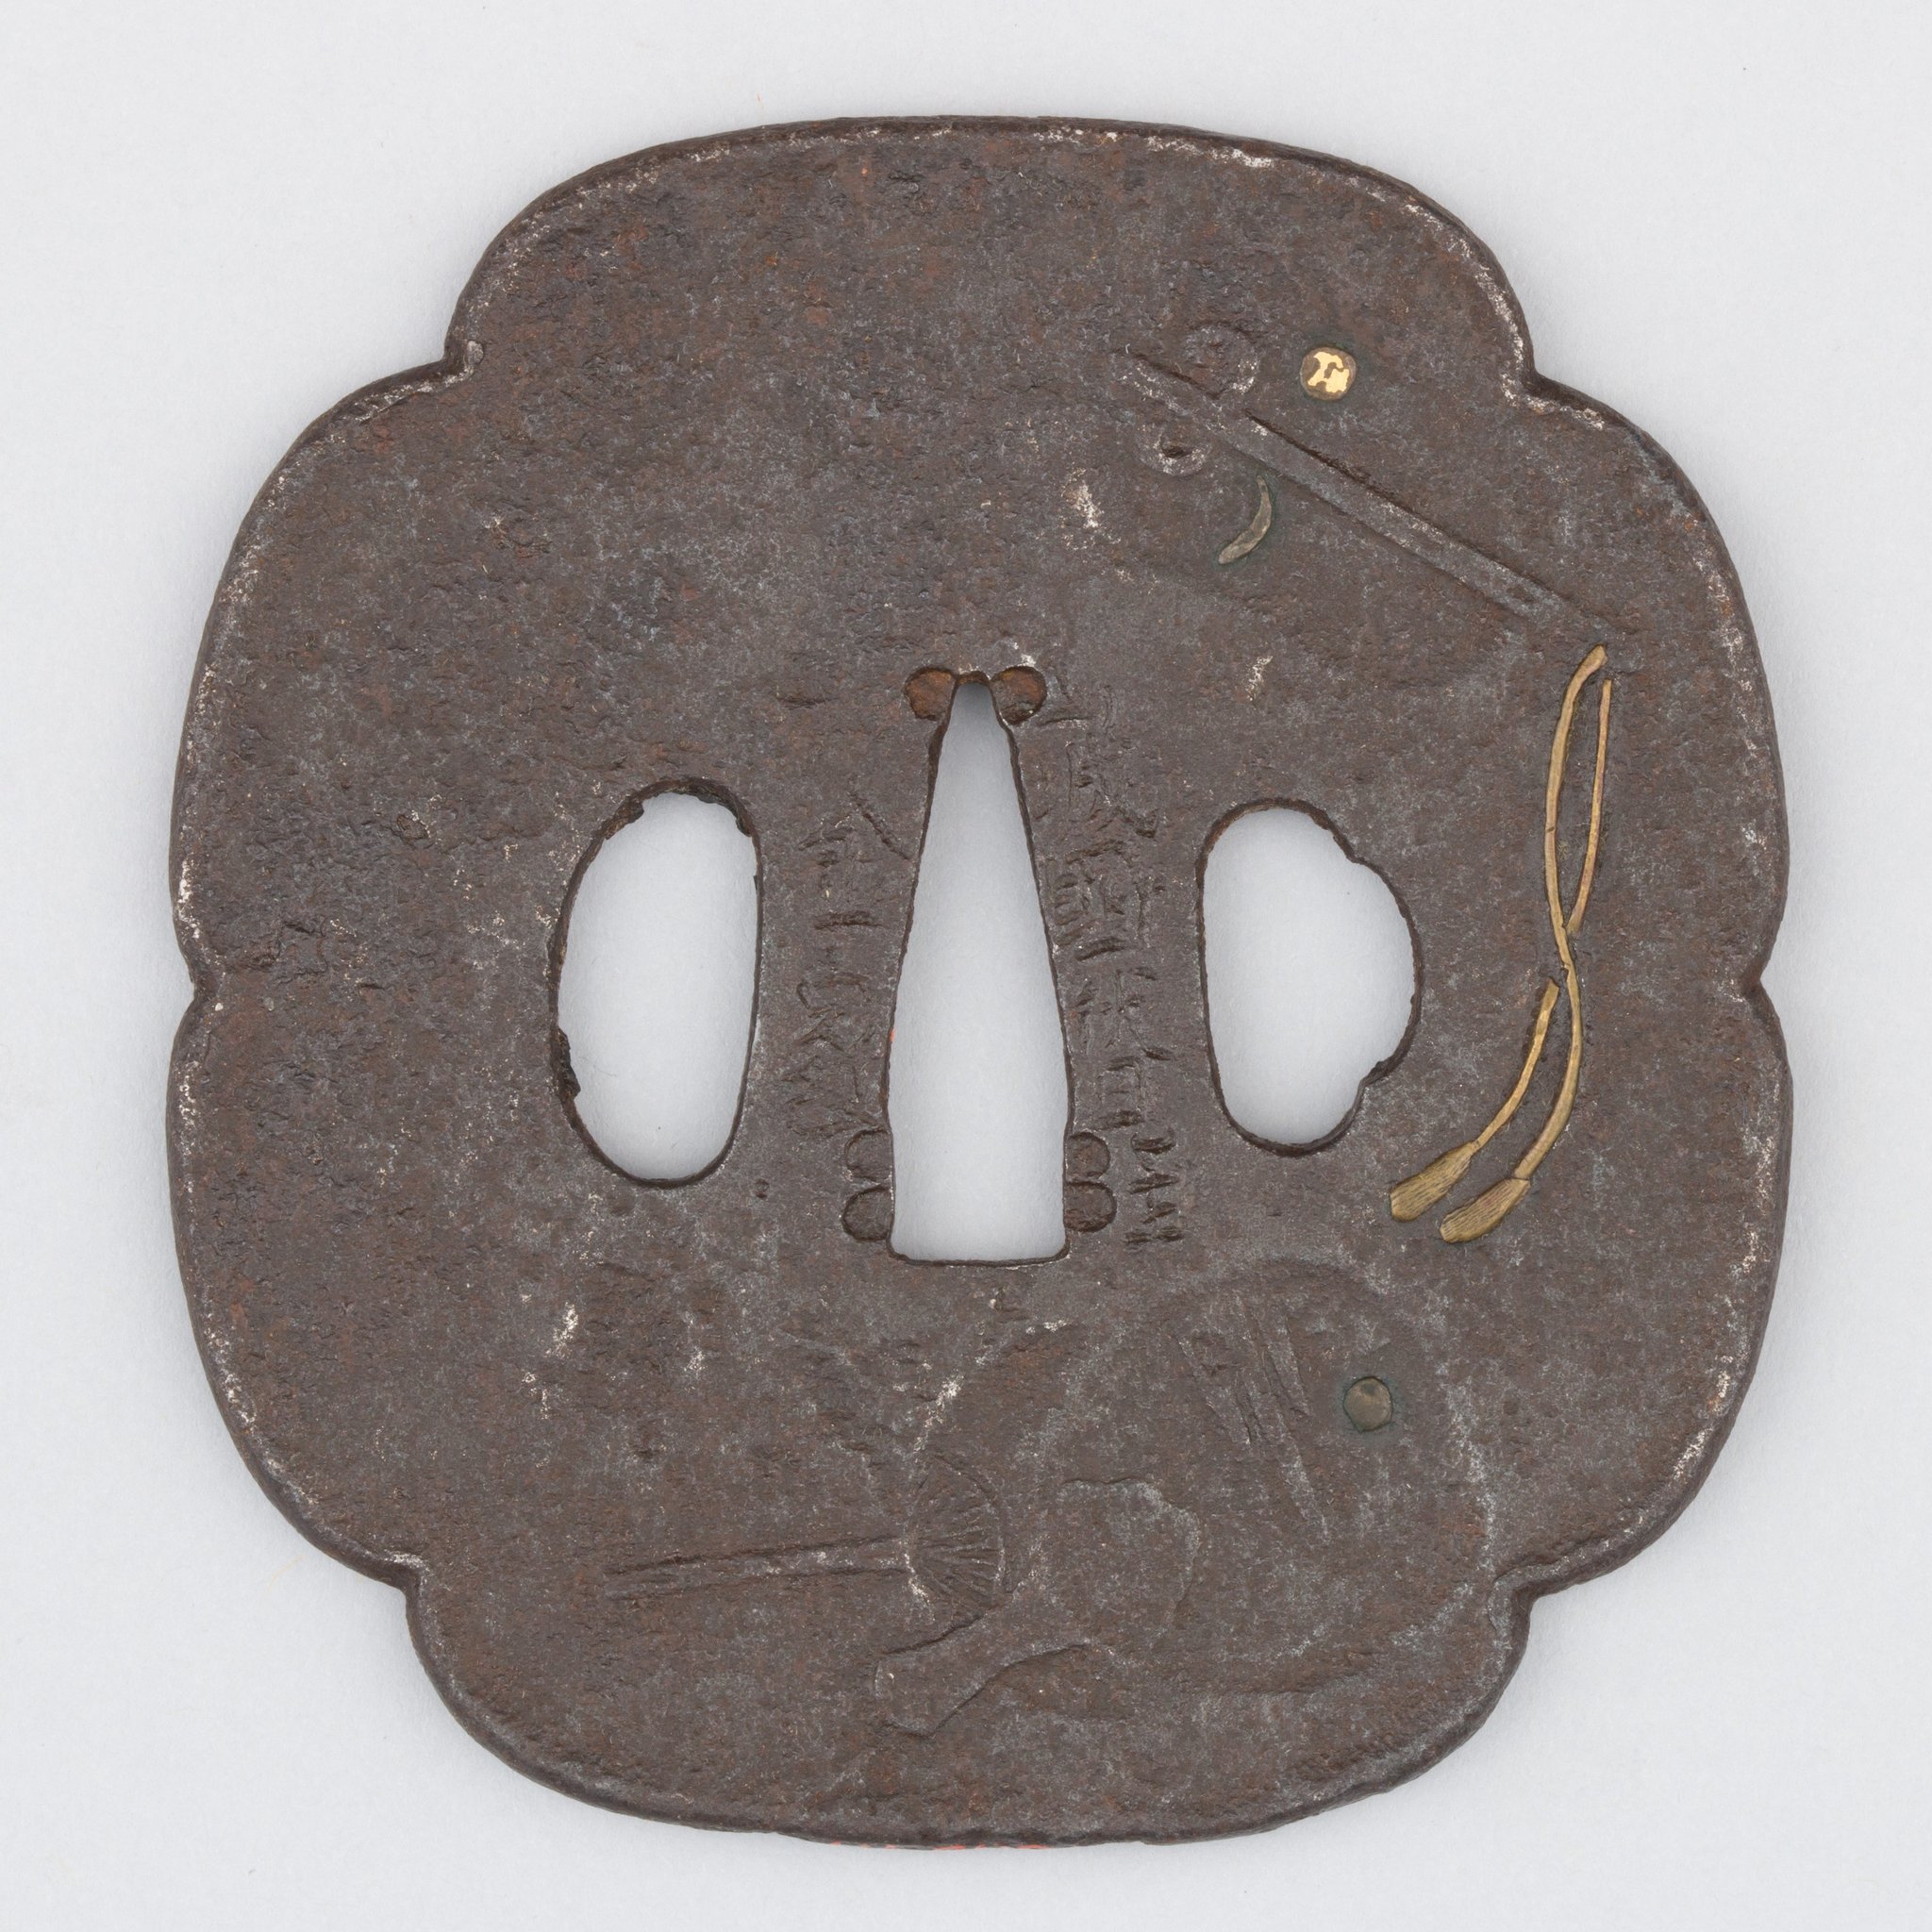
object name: sword guard tsuba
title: Sword Guard (Tsuba)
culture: japanese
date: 1601-1700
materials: copper alloy, gold, iron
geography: japan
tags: fans